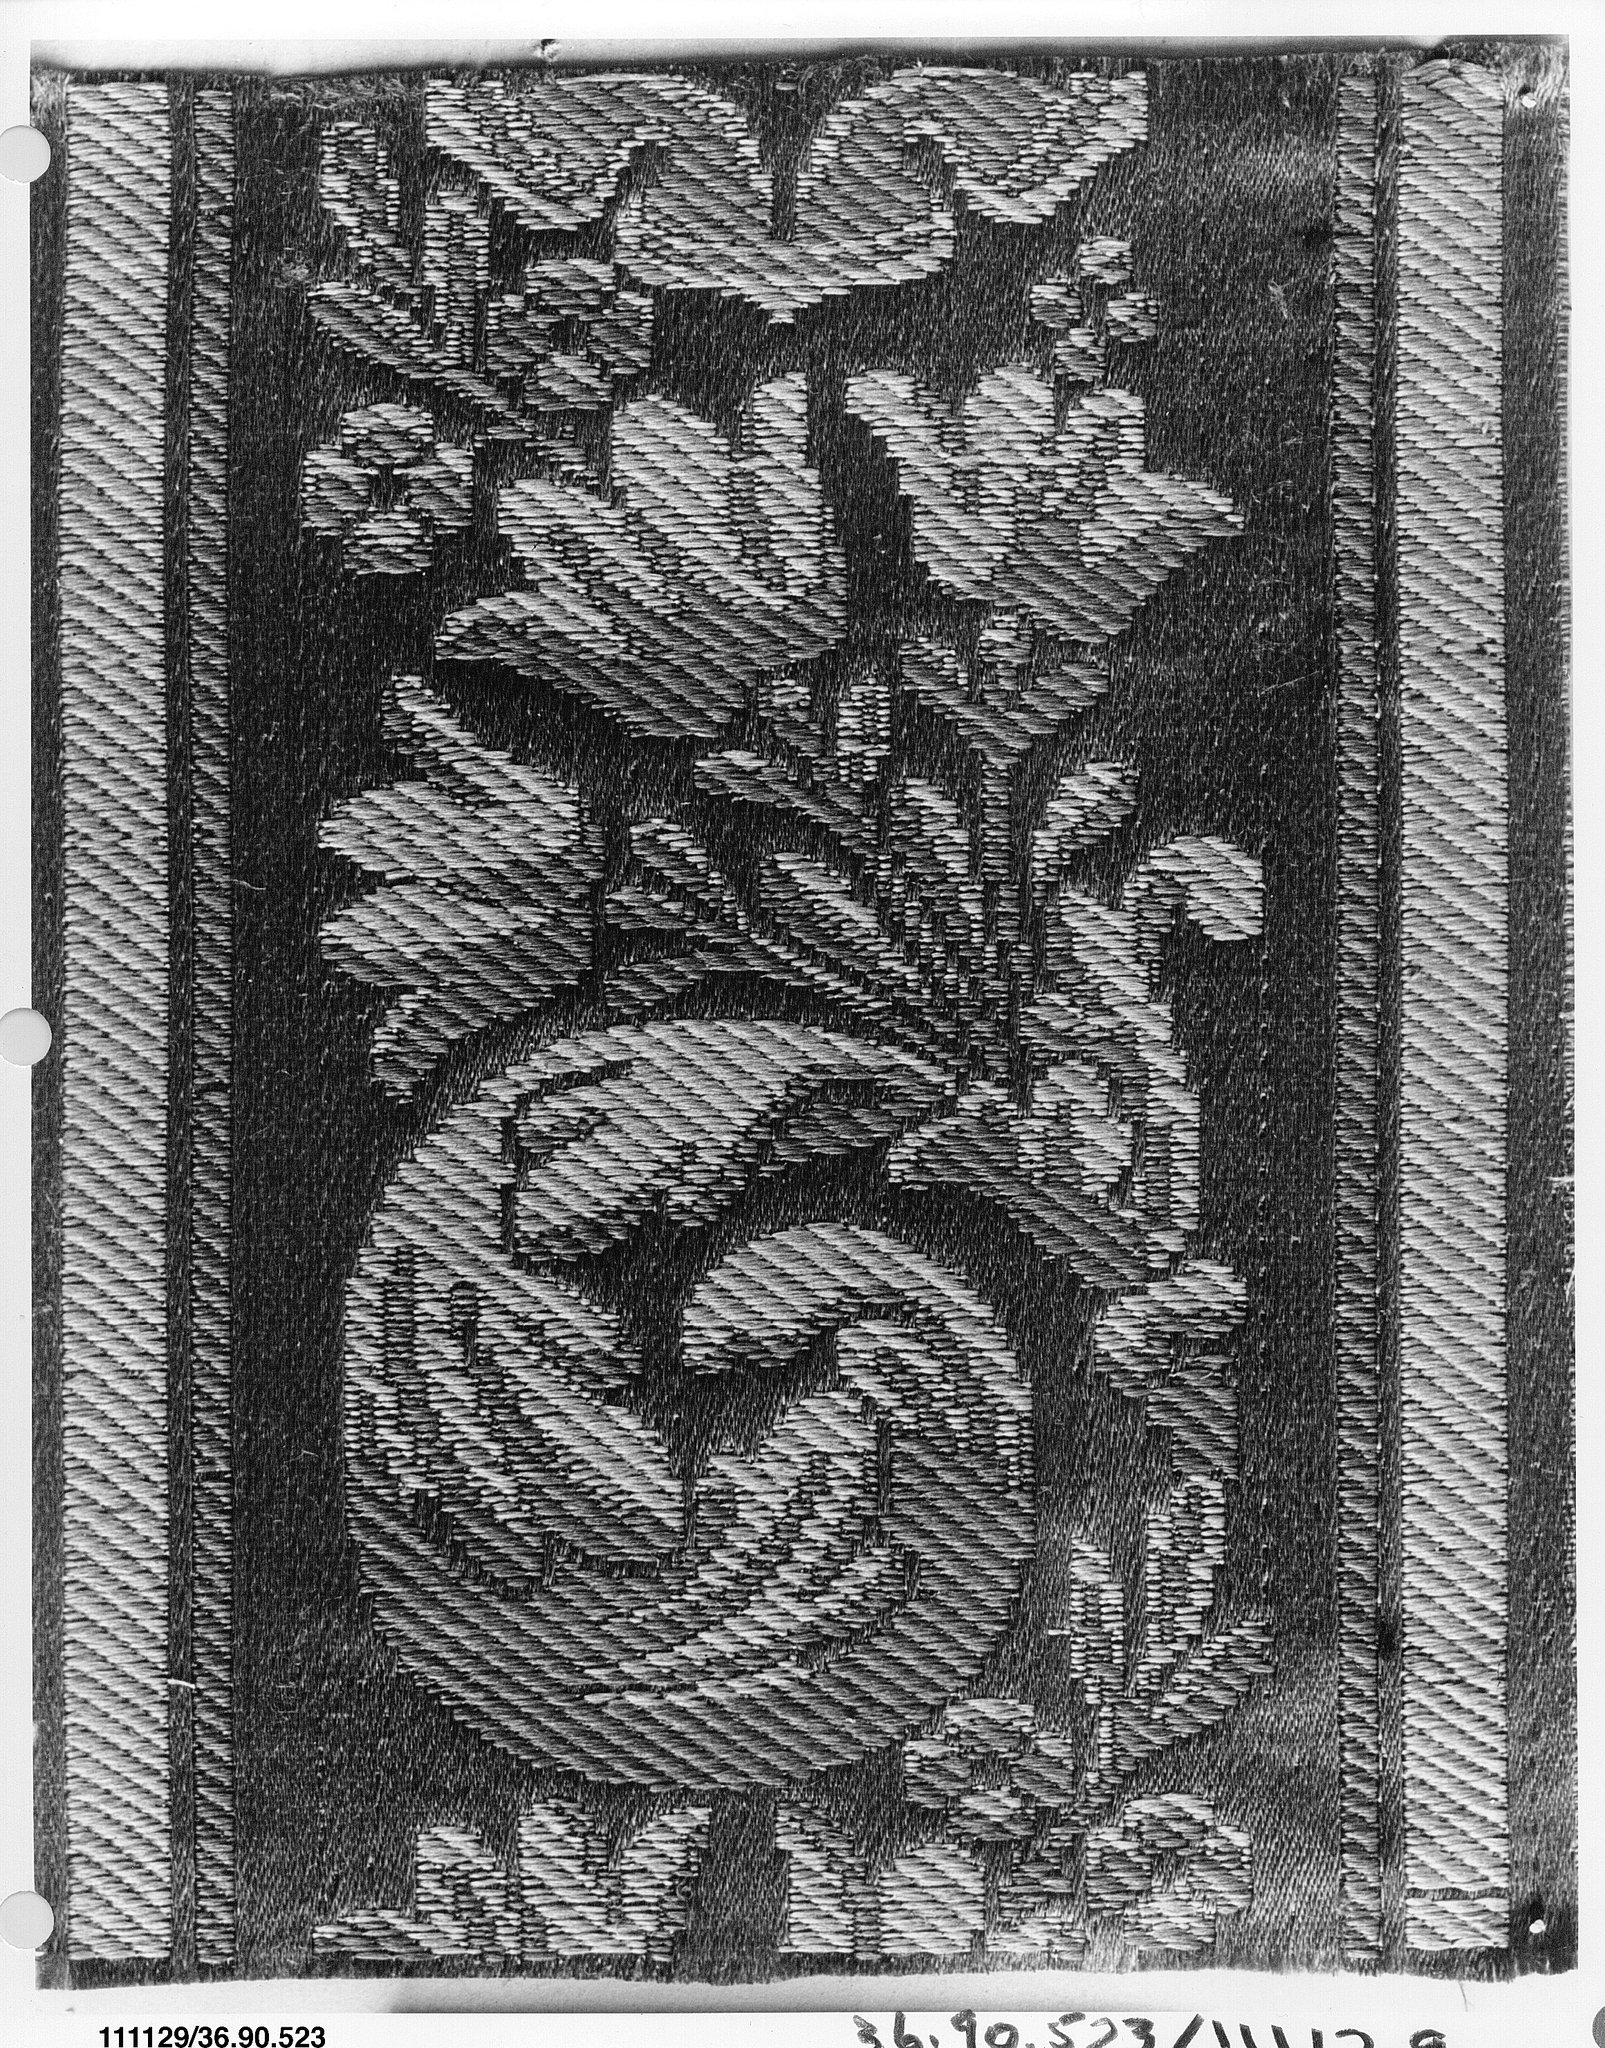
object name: piece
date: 1801-1833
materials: silk